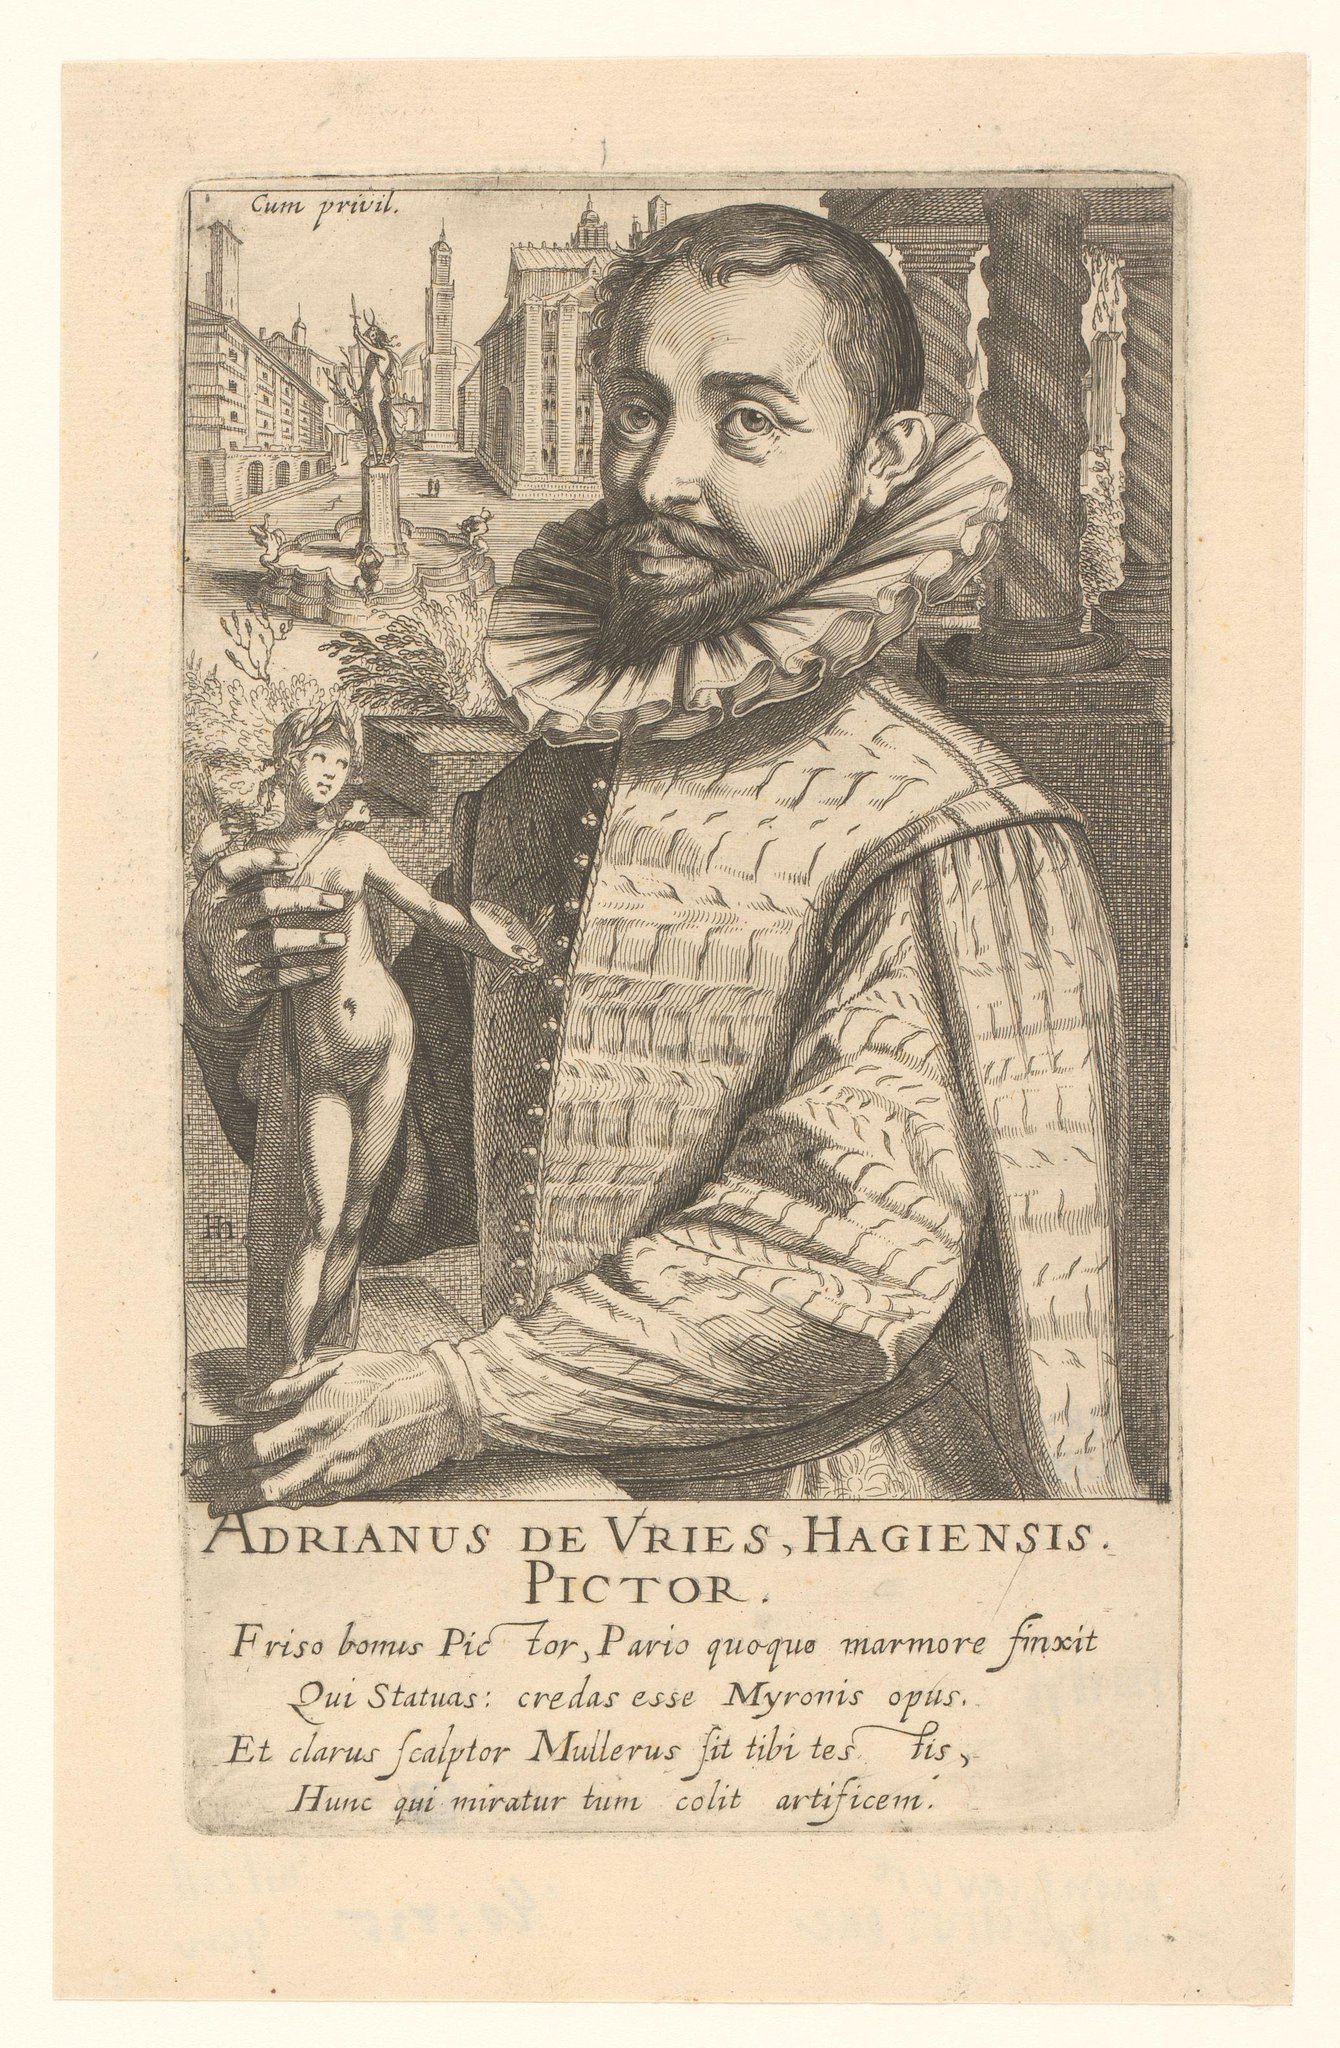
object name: print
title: Adrianus de Vries, Hagiensis. Pictor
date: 1610-1618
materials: paper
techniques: engraving, etching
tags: the hague, prague, sculptor, adriaen de vries, portrait, self-portrait of sculptor, historical persons, palette, ornamental fountain, sculpture, city-view in general; 'veduta' (+ city(-scape) with figures, staffage)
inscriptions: collector's mark: Lugt 2760, collector's mark: Lugt 2166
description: Prent uit deel 3 van de serie Pictorum Aliquot Celebrium Praecipuae Germaniae Inferioris Effigies. Serie van 72 kunstenaarsportretten vervaardigd door Hendrick Hondius I, Simon Frisius, Andries Jacobsz. Stock en Robert de Baudous. Prent ook gebruikt voor de serie 'Theatrum honoris in quo nostri Apelles saeculi', in 1612 en 1618 uitgegeven.